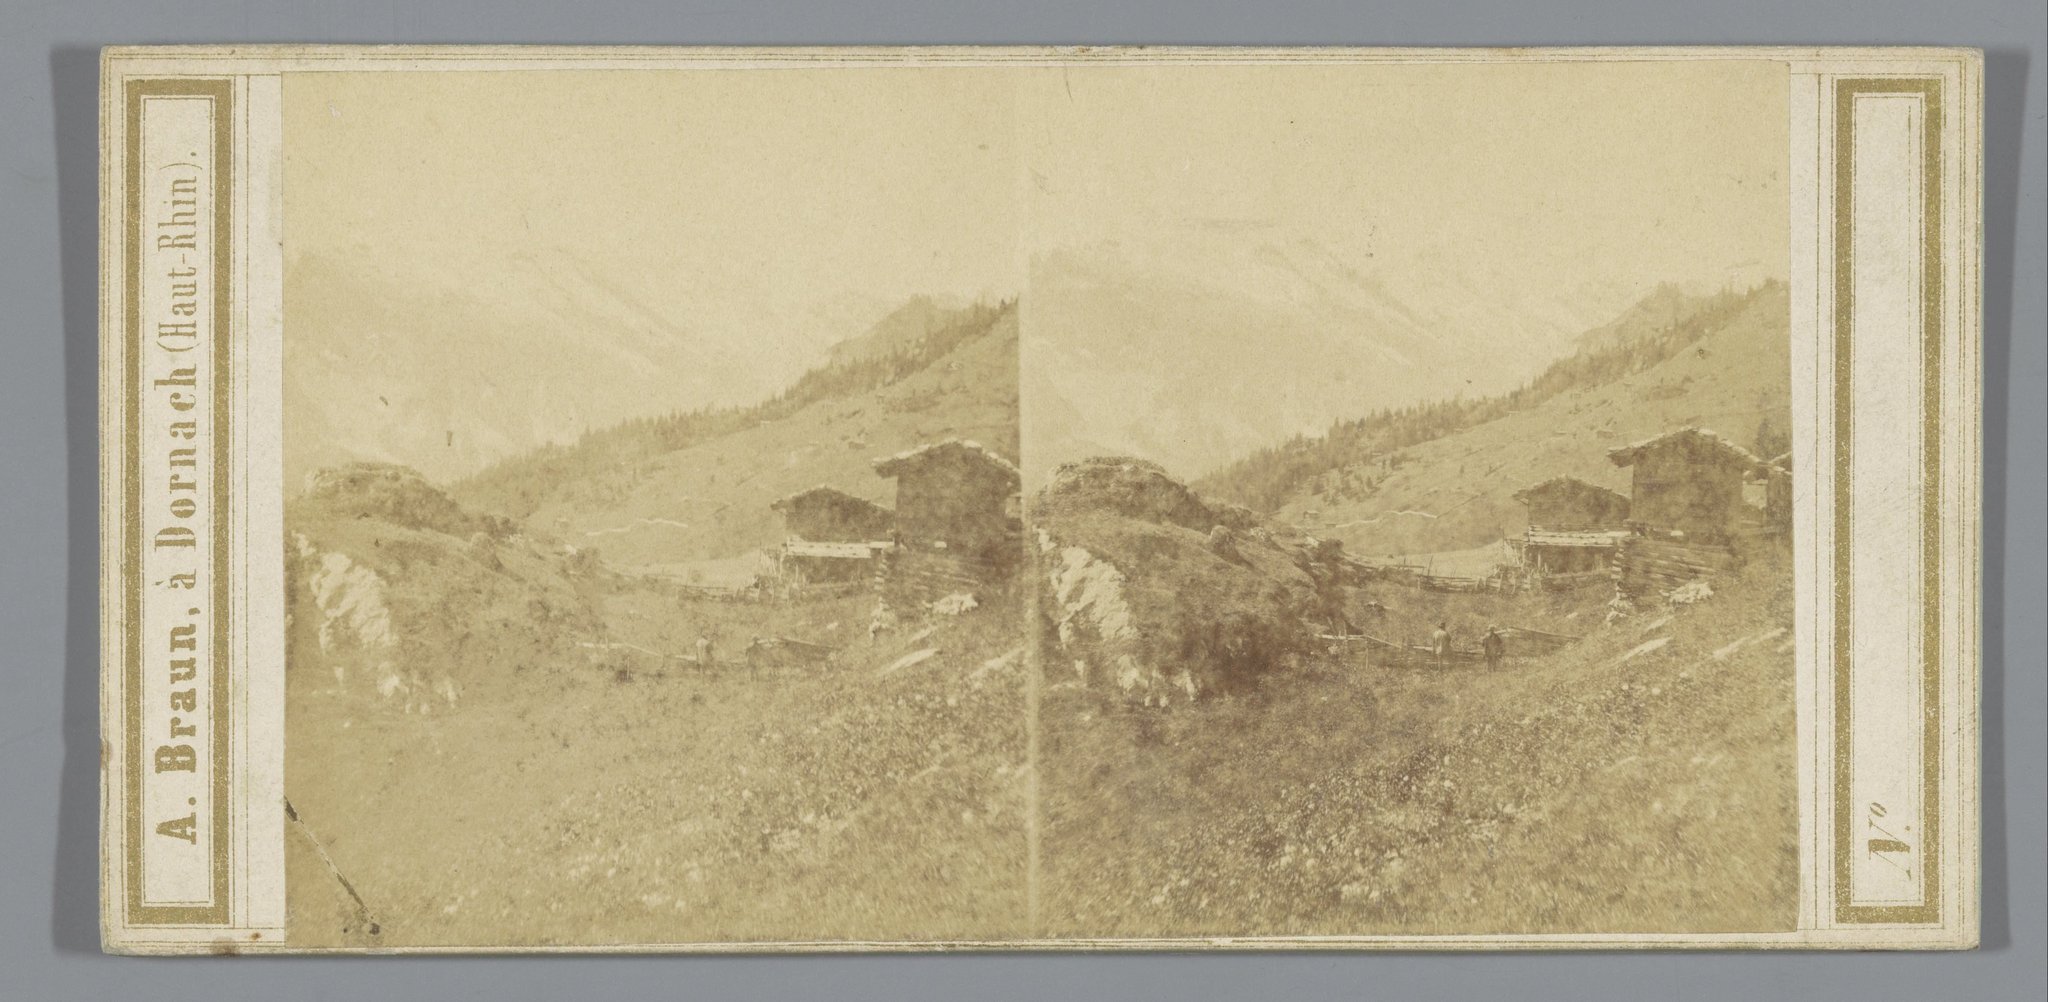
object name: stereograph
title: Bergdal nabij Mürren, Zwitserland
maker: Anonymous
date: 1860-1866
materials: cardboard, paper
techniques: albumen print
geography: dornach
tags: dale, valley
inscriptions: number: ‘745.’